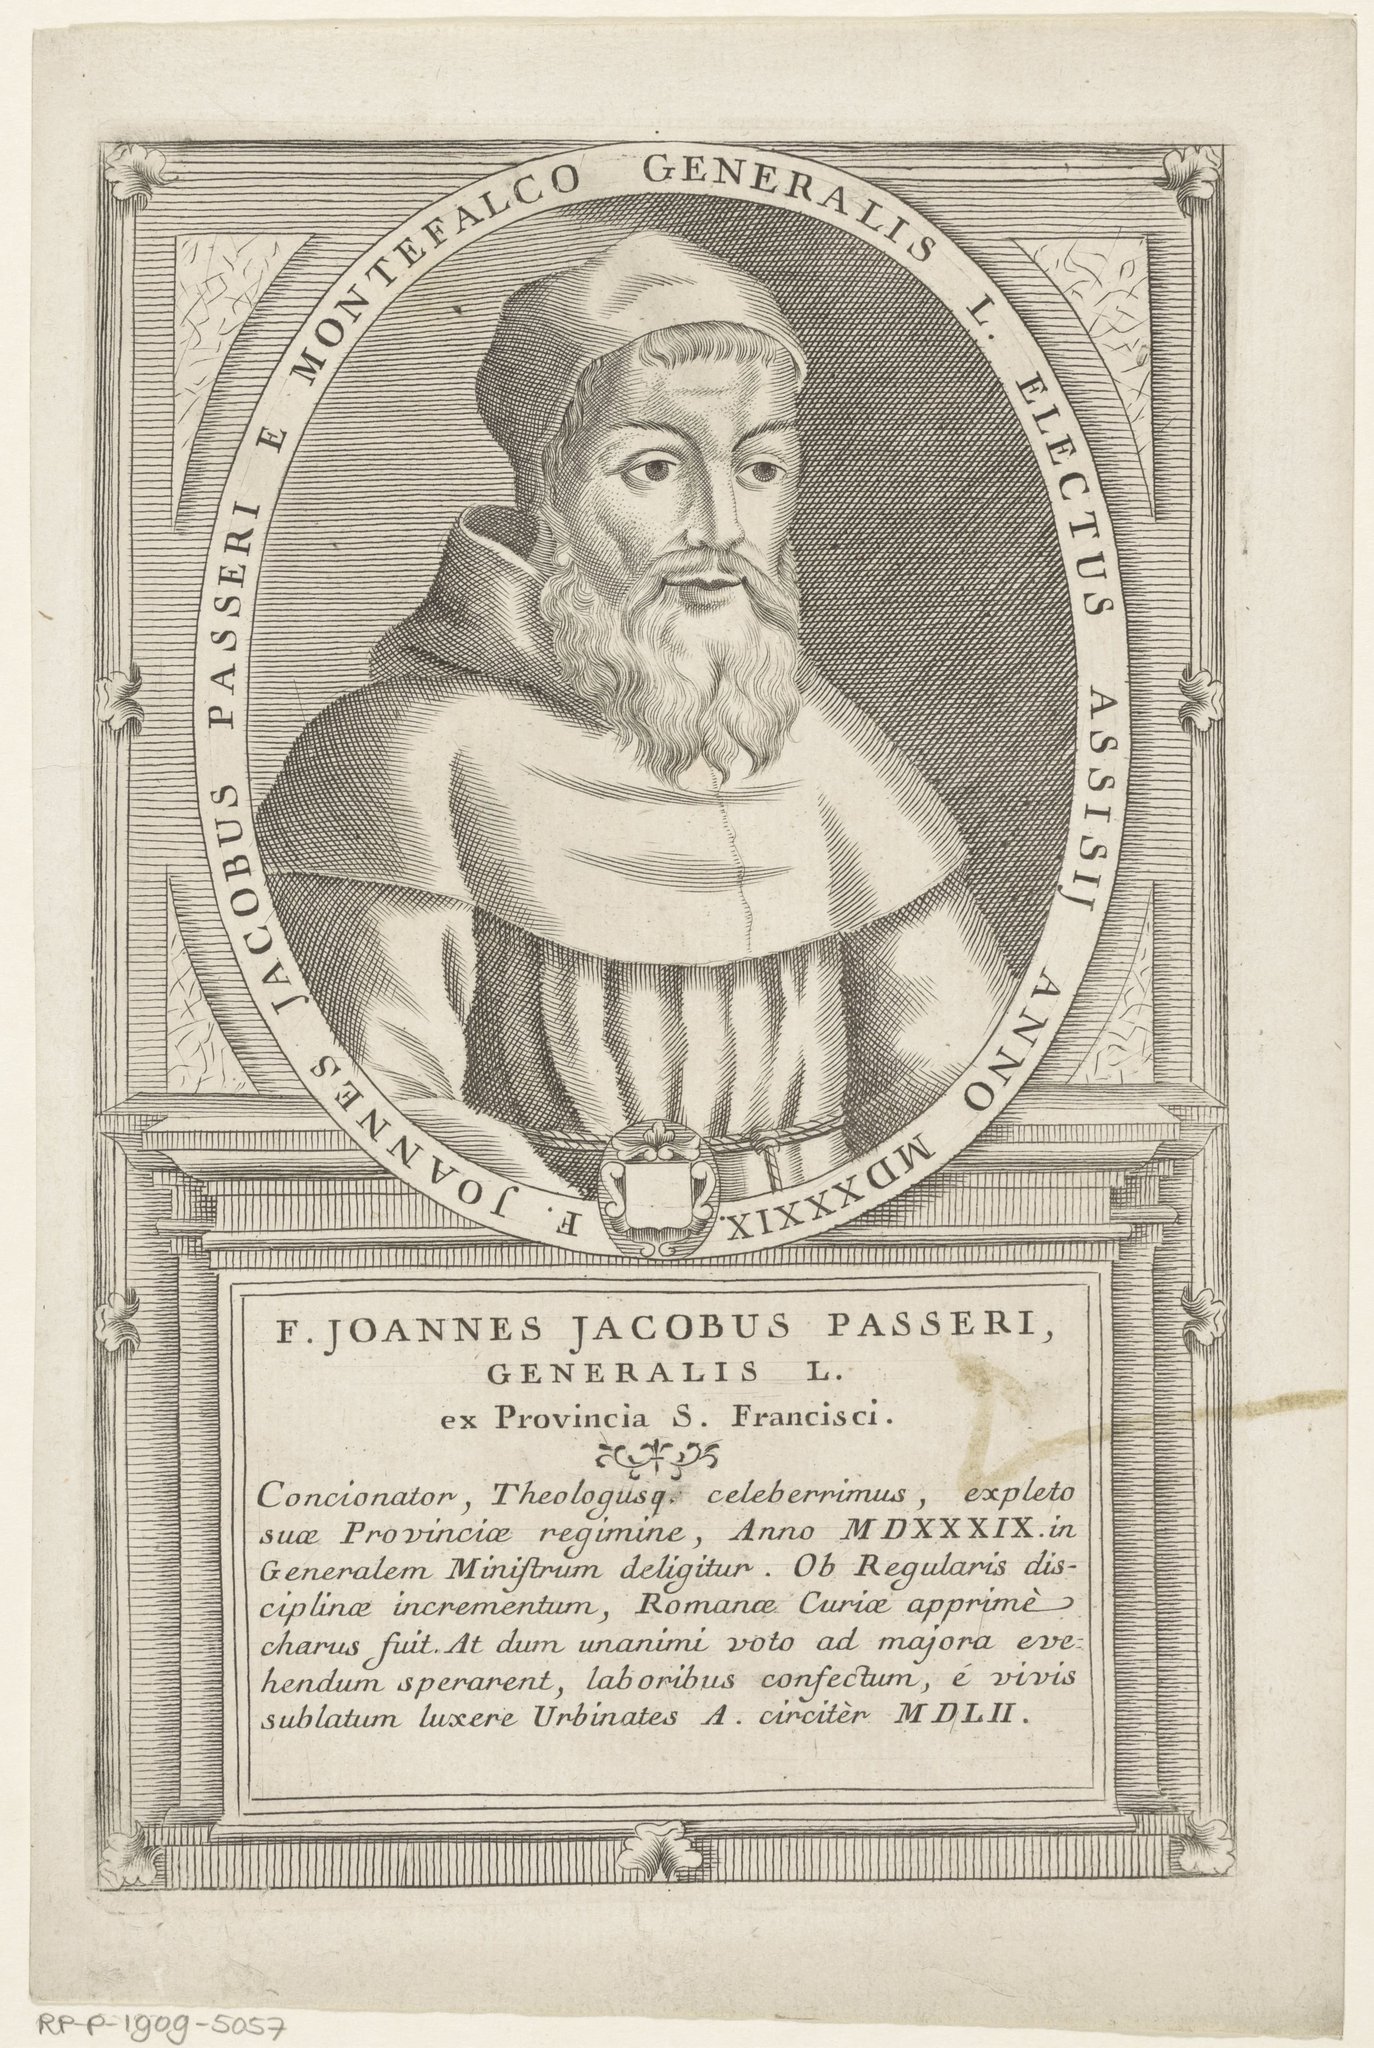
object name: print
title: Portret van Juan Jaime Passeri, 50ste Minister Generaal van de franciscaner orde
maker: antonio luciani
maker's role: print maker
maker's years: 1700-1738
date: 1710-1738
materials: paper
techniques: engraving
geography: italy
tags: clergyman, historical persons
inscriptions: collector's mark: Lugt 2228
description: Deze prent maakt deel uit van een groep van 60 portretten.